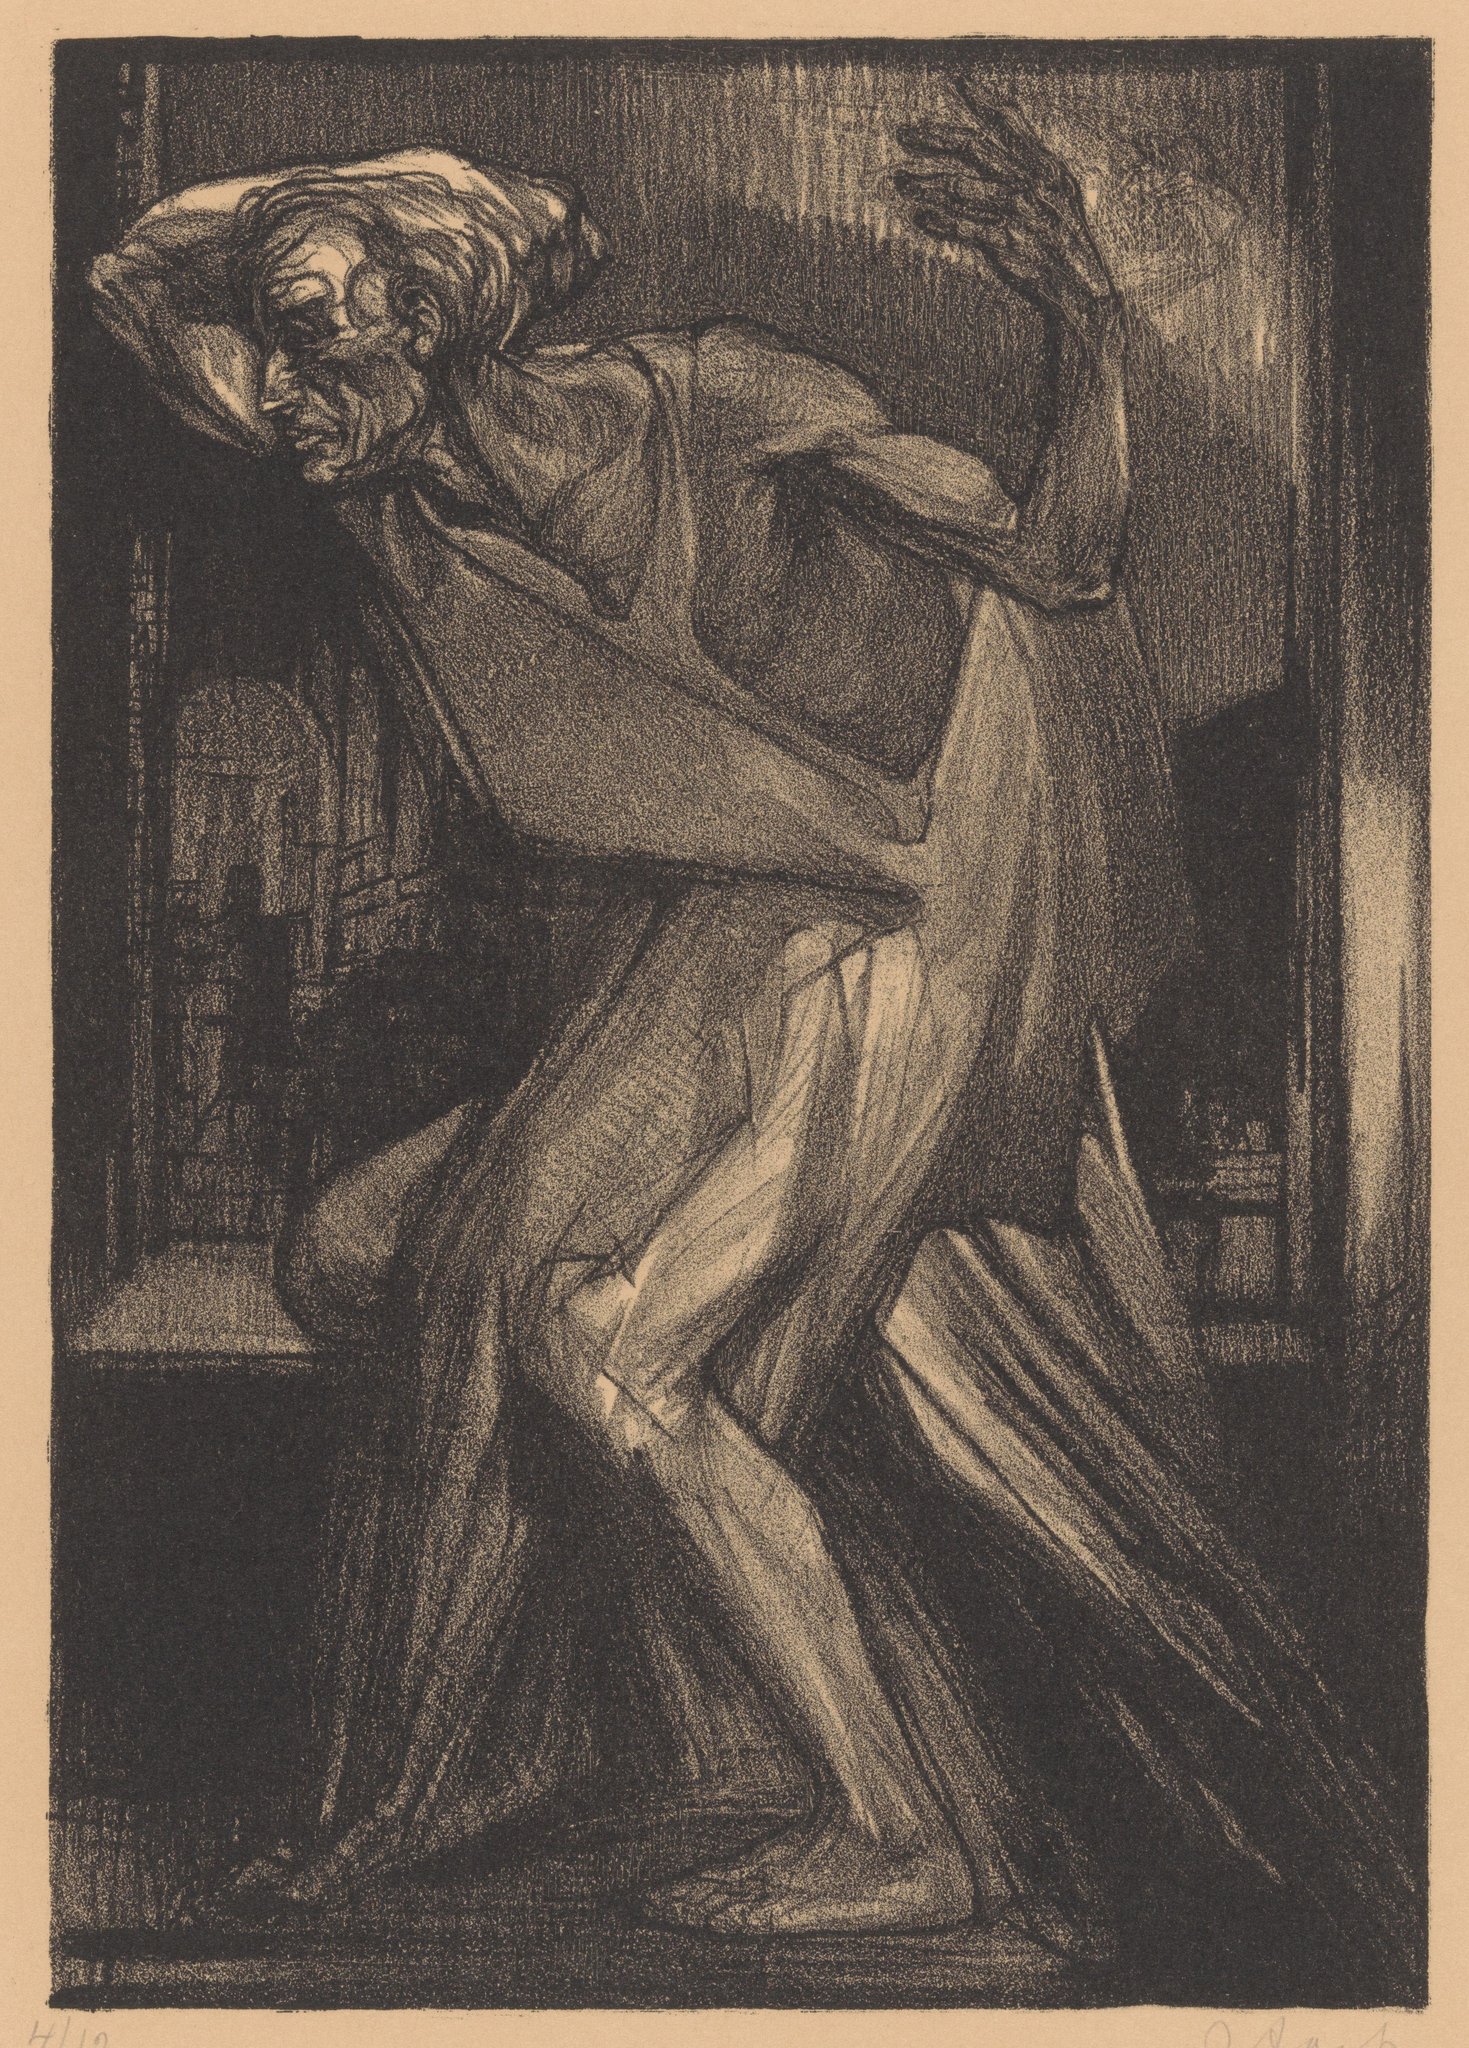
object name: print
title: Man in gewaad met gebogen armen en benen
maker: johannes josephus aarts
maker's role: draughtsman, print maker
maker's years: 1871-1934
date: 1927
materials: paper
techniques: lithograph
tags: both legs bent, arm or hand bent behind the body - aa - both arms or hands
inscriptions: collector's mark: Lugt 2760, collector's mark: Lugt 2228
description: Deze prent is mogelijk geïnspireerd op de dichtbundel 'Les Apparus dans mes chemins' van Émile Verhaeren uit 1891.